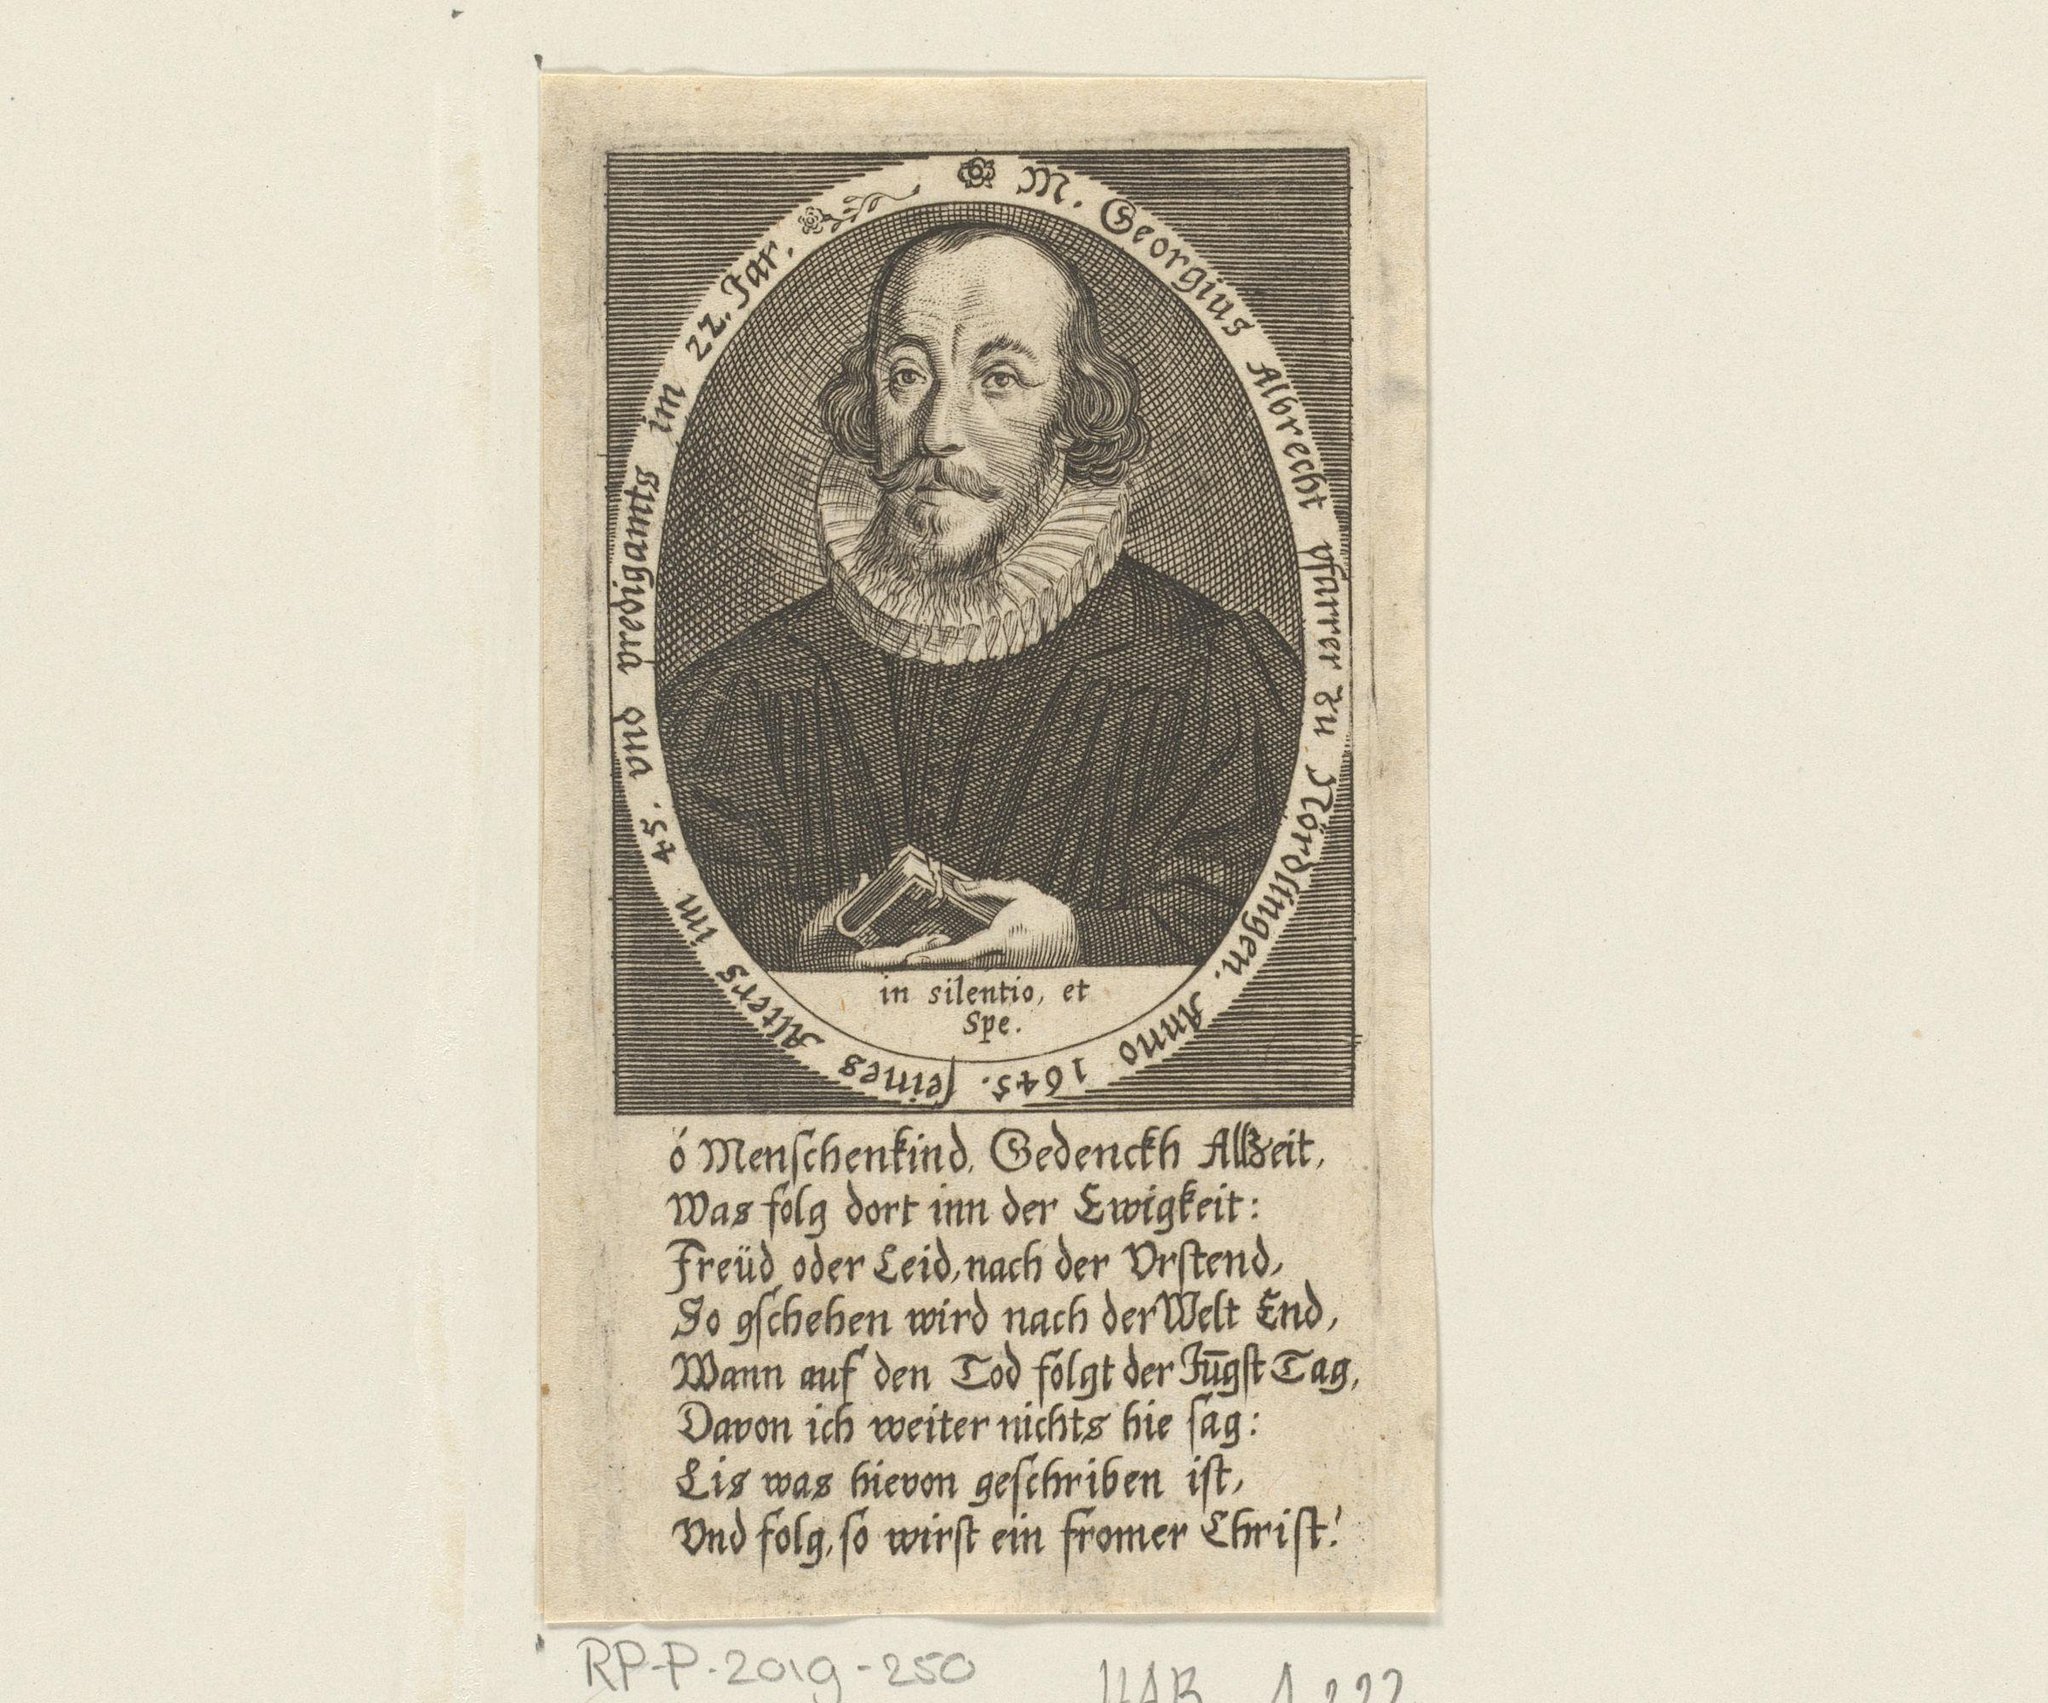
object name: print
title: Portret van Georg Albrecht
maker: Anonymous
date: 1645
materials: paper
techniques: engraving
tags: georg albrecht, theologian, historical persons, book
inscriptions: date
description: Onder het portret een achtregelig vers over de geportretteerde.